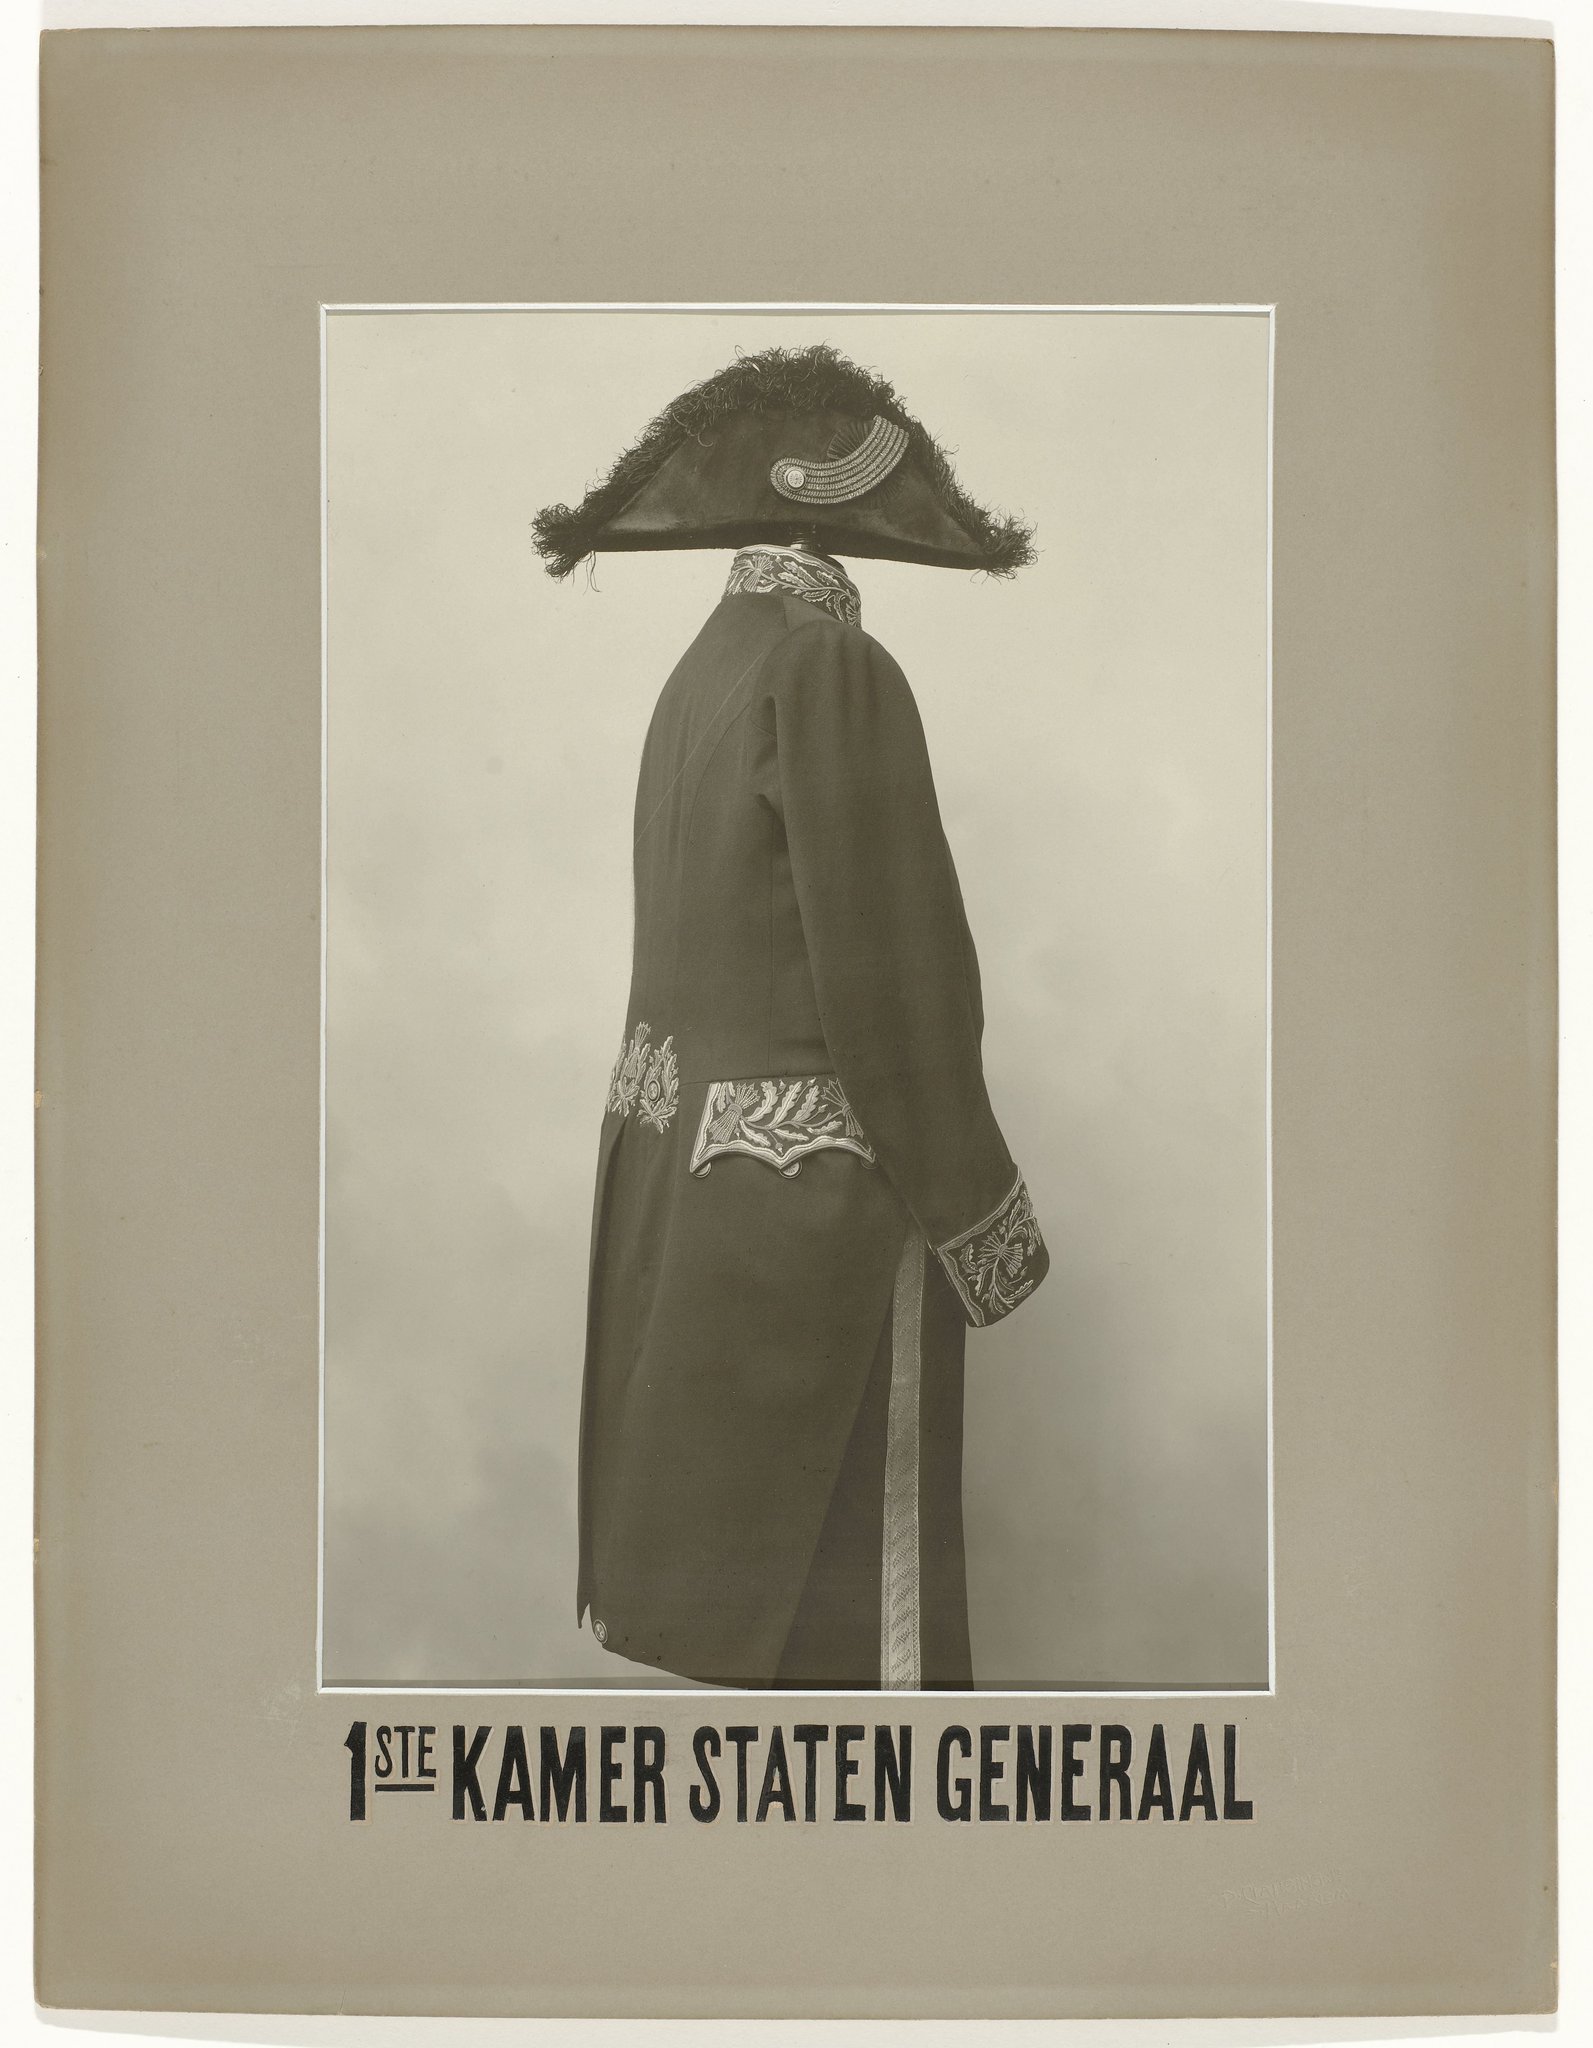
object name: photograph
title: 1ste kamer Staten Generaal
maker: peter clausing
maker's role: fotograaf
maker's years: 1870-1913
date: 1875-1900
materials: cardboard, paper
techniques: photography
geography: haarlem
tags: netherlands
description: Eén van acht foto's van ambtskostuums, in grijsbruin passe-partout met onder benaming in verf, kapitalen, zwarte letter met witte 'schaduw'. Onderschrift: 1ste KAMER STATEN GENERAAL. Gemerkt; r.o.: reliëfstempel: 'P. Clausing jr / Haarlem'. Opmerking: zie NG-1029-A t/m H.